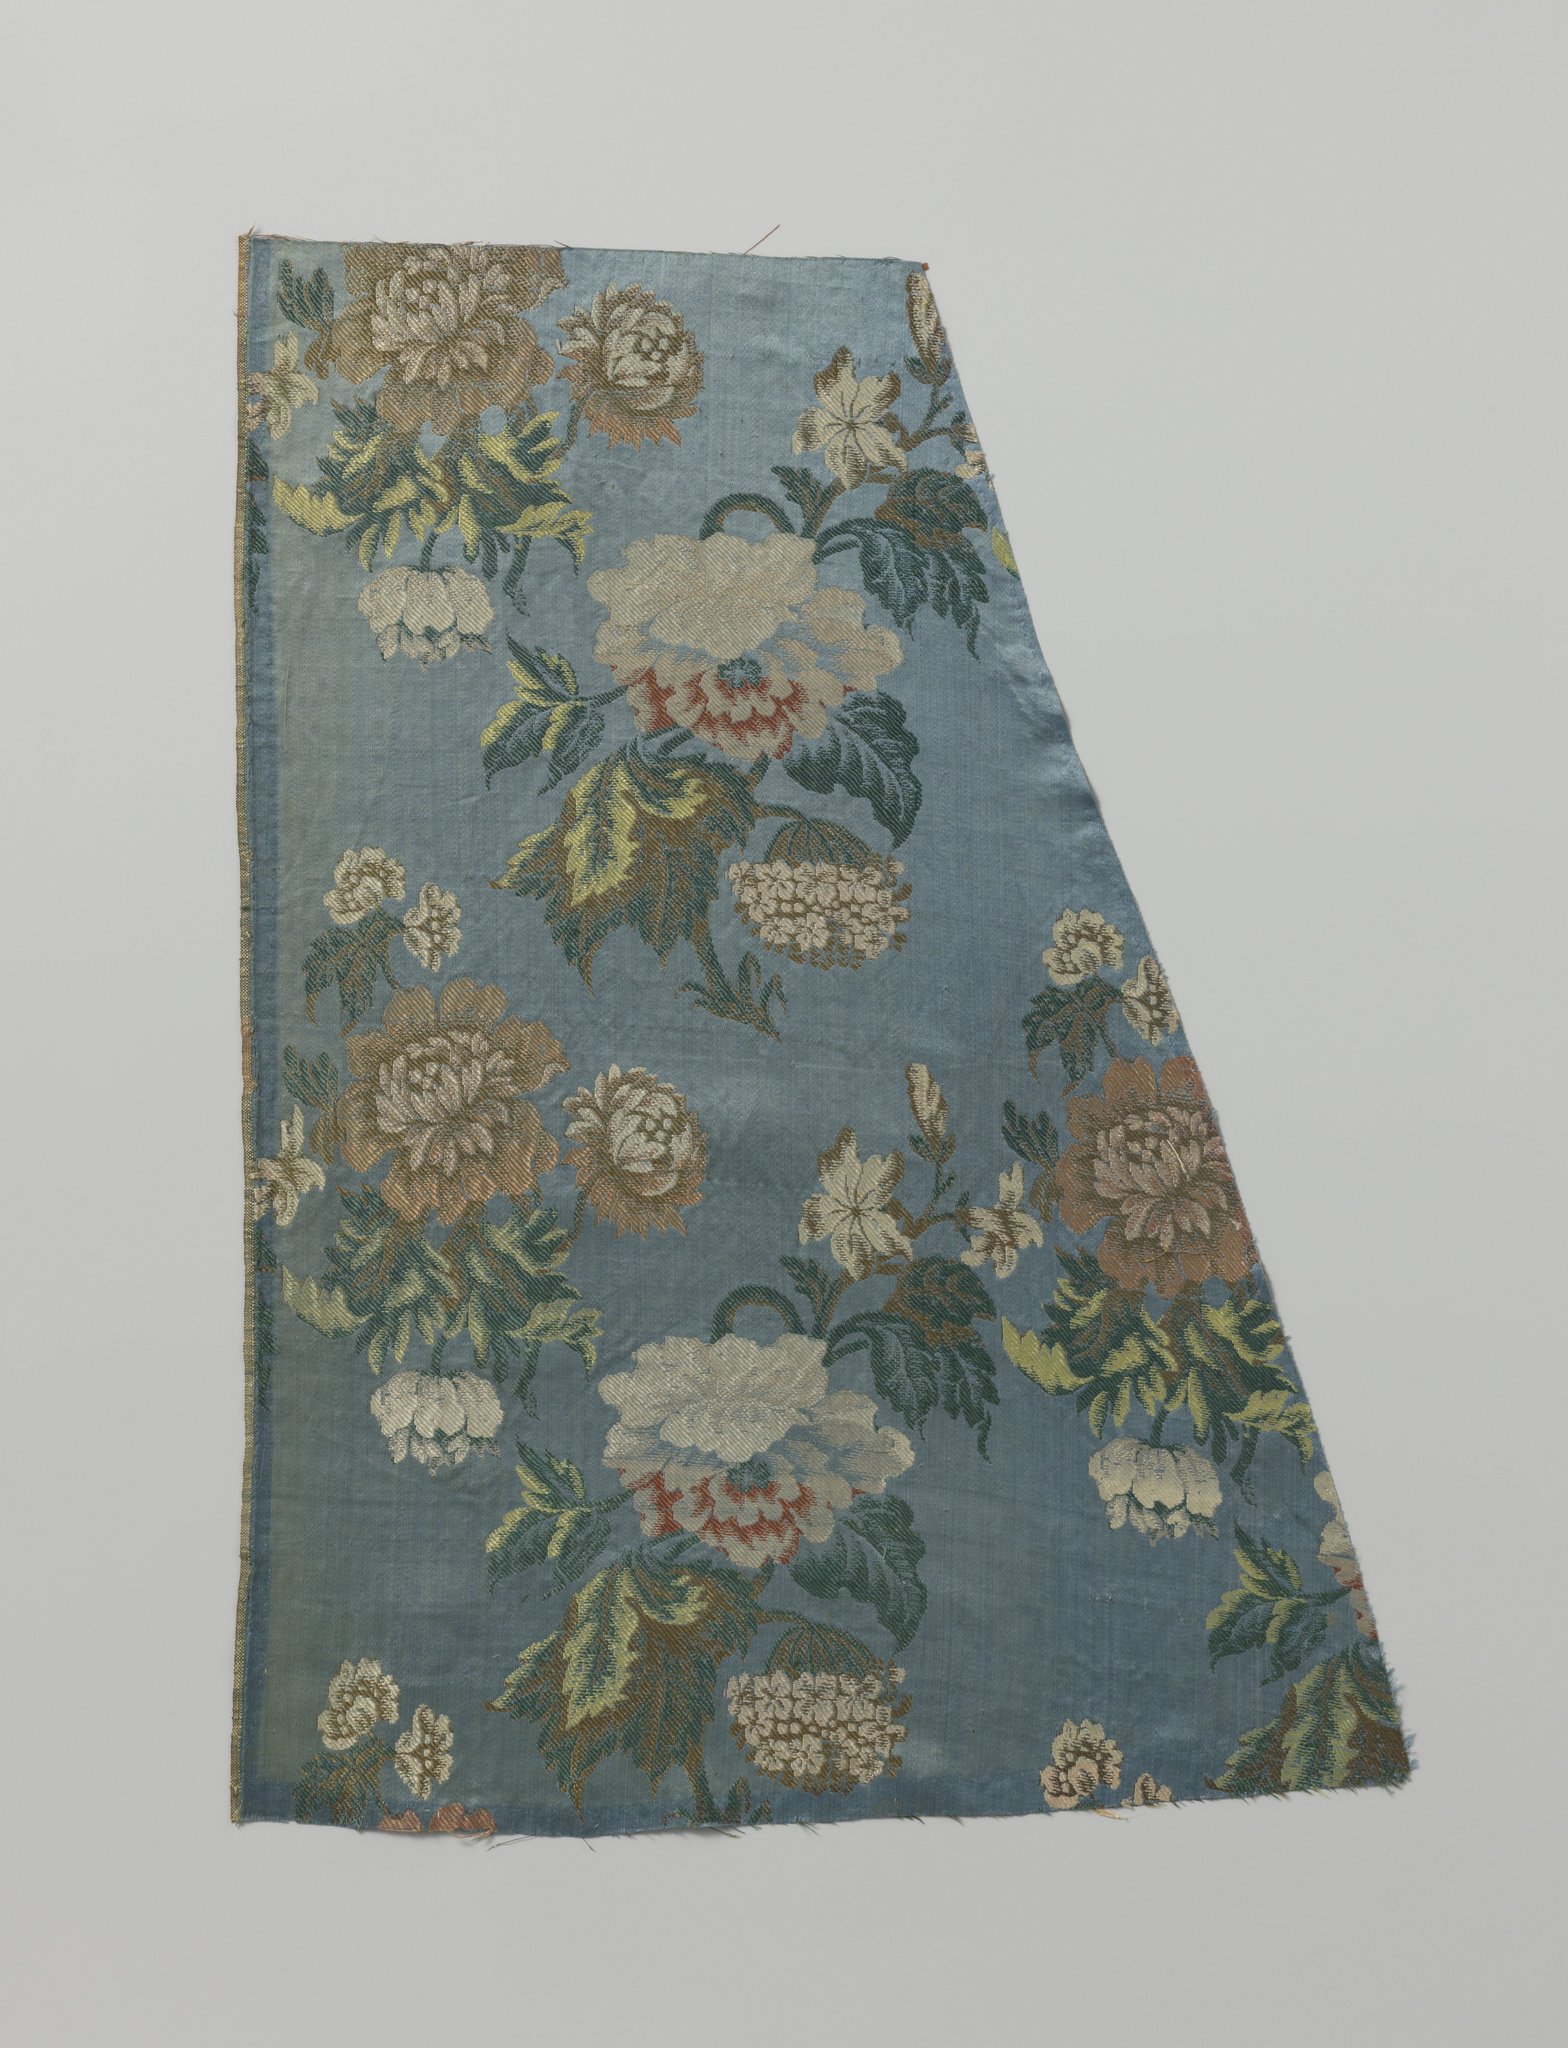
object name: woven material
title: Fragment veelkleurige gebrocheerde zijde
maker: Anonymous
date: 1750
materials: silk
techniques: brocade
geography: spain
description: Drie fragmenten veelkleurig zijdeweefsel. Het patroon heeft veelkleurige bloemen op een blauwe grond.